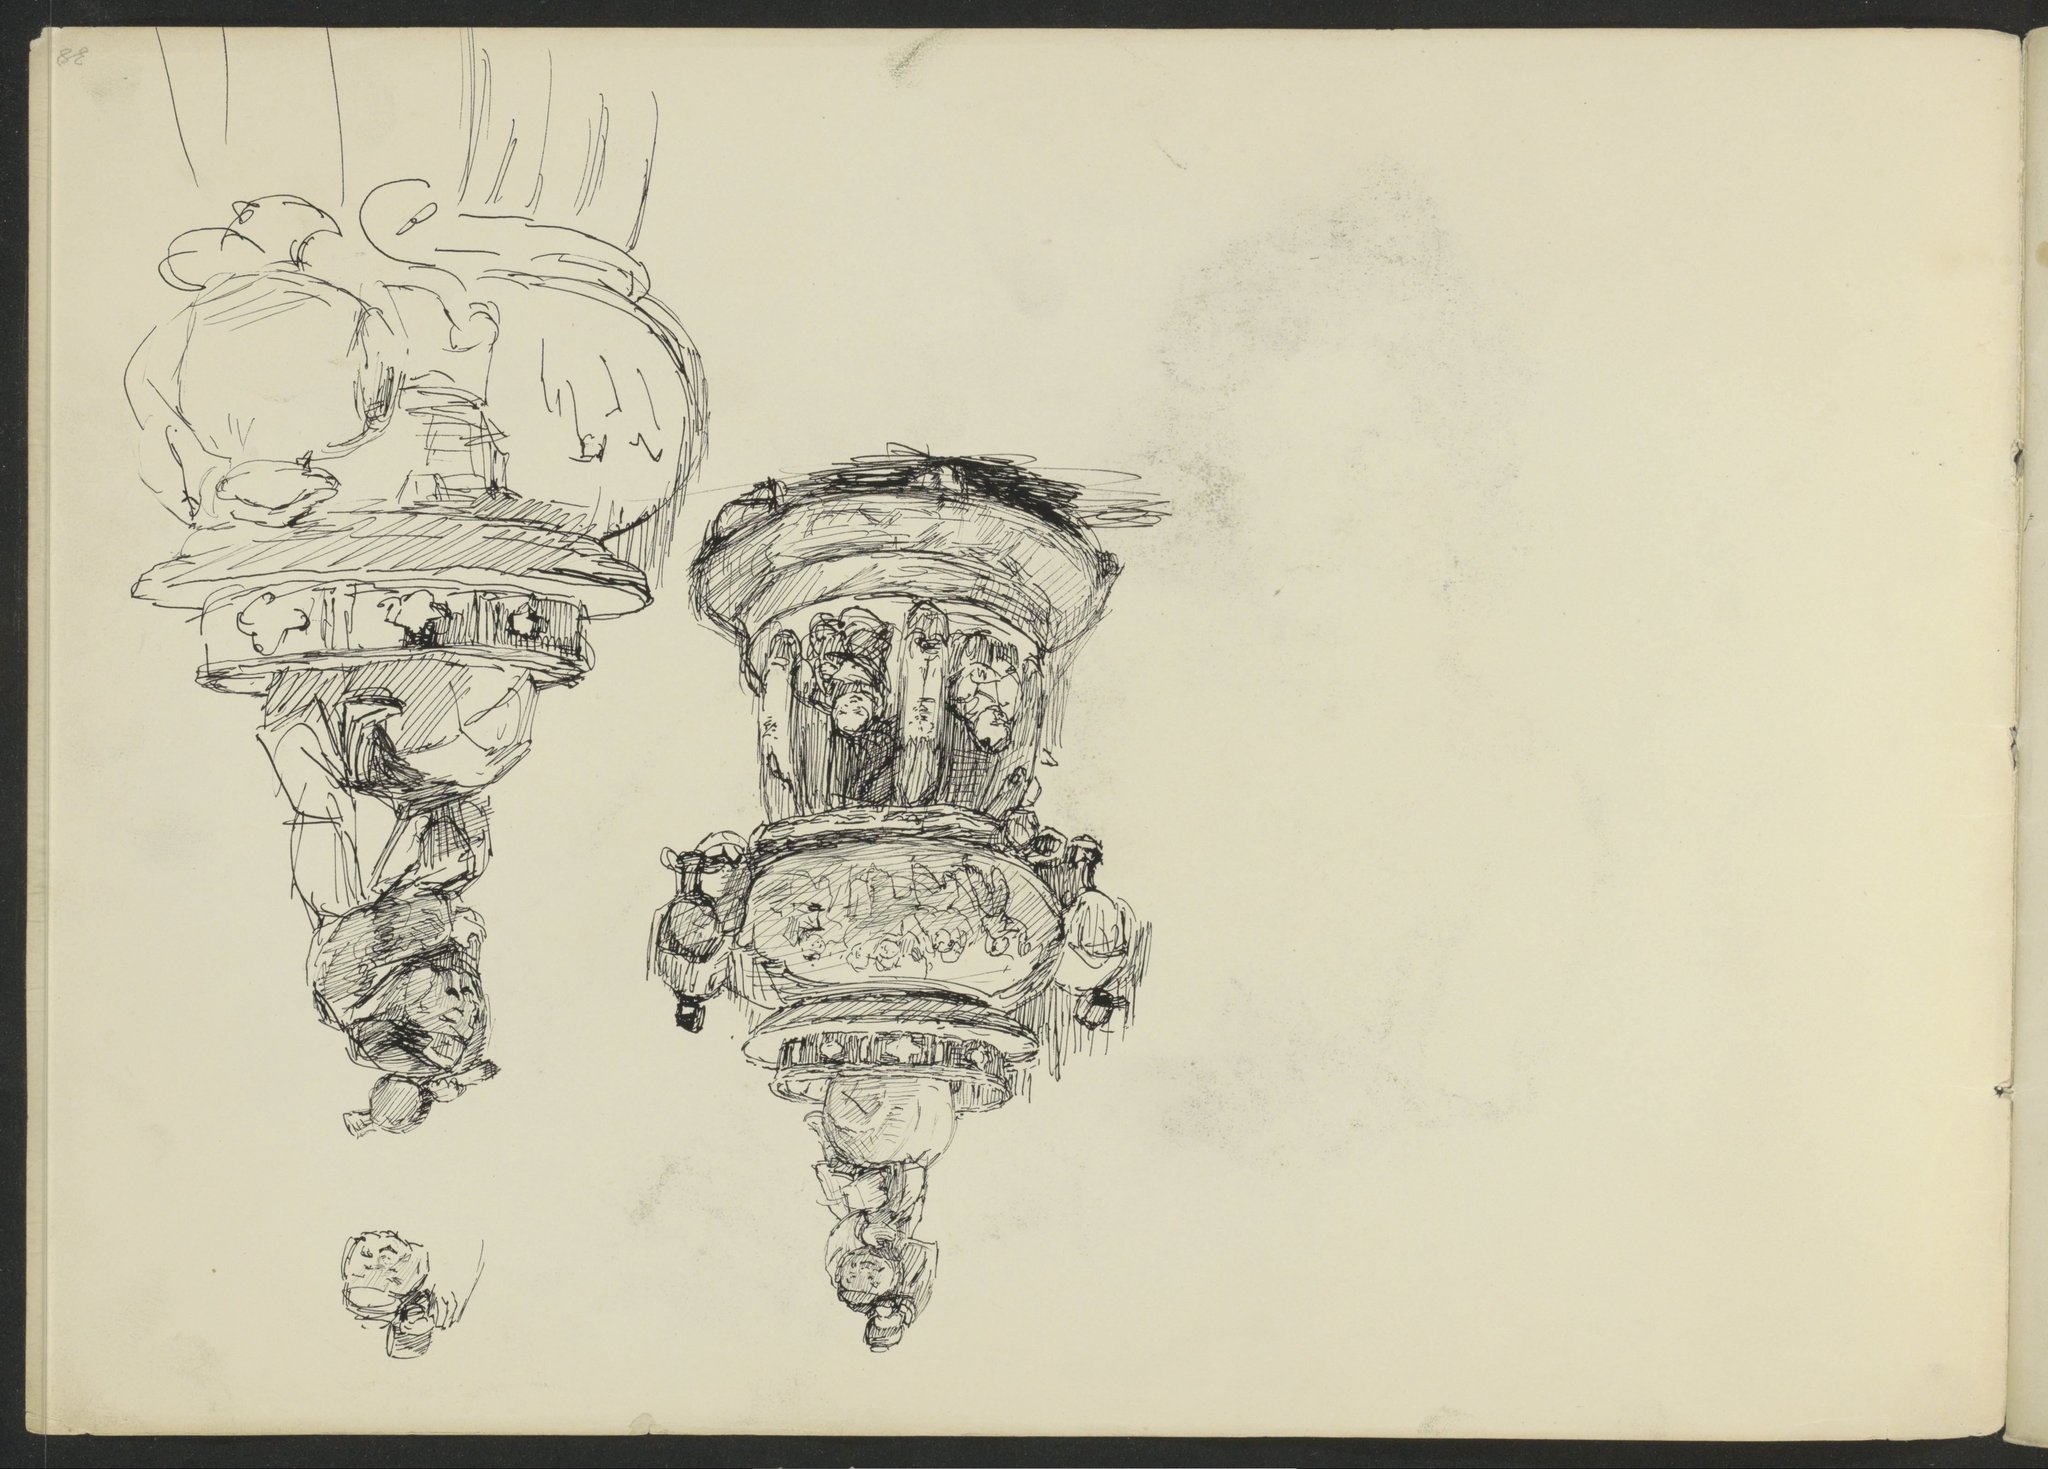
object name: endleaf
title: Voorwerp, mogelijk een bierpomp of samovar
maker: isaac israels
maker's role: draughtsman, painter, print maker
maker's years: 1865-1934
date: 1875-1934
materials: ink, paper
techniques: pen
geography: the hague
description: Blad 1 verso, voorste schutblad, uit schetsboek XII met 19 bladen.